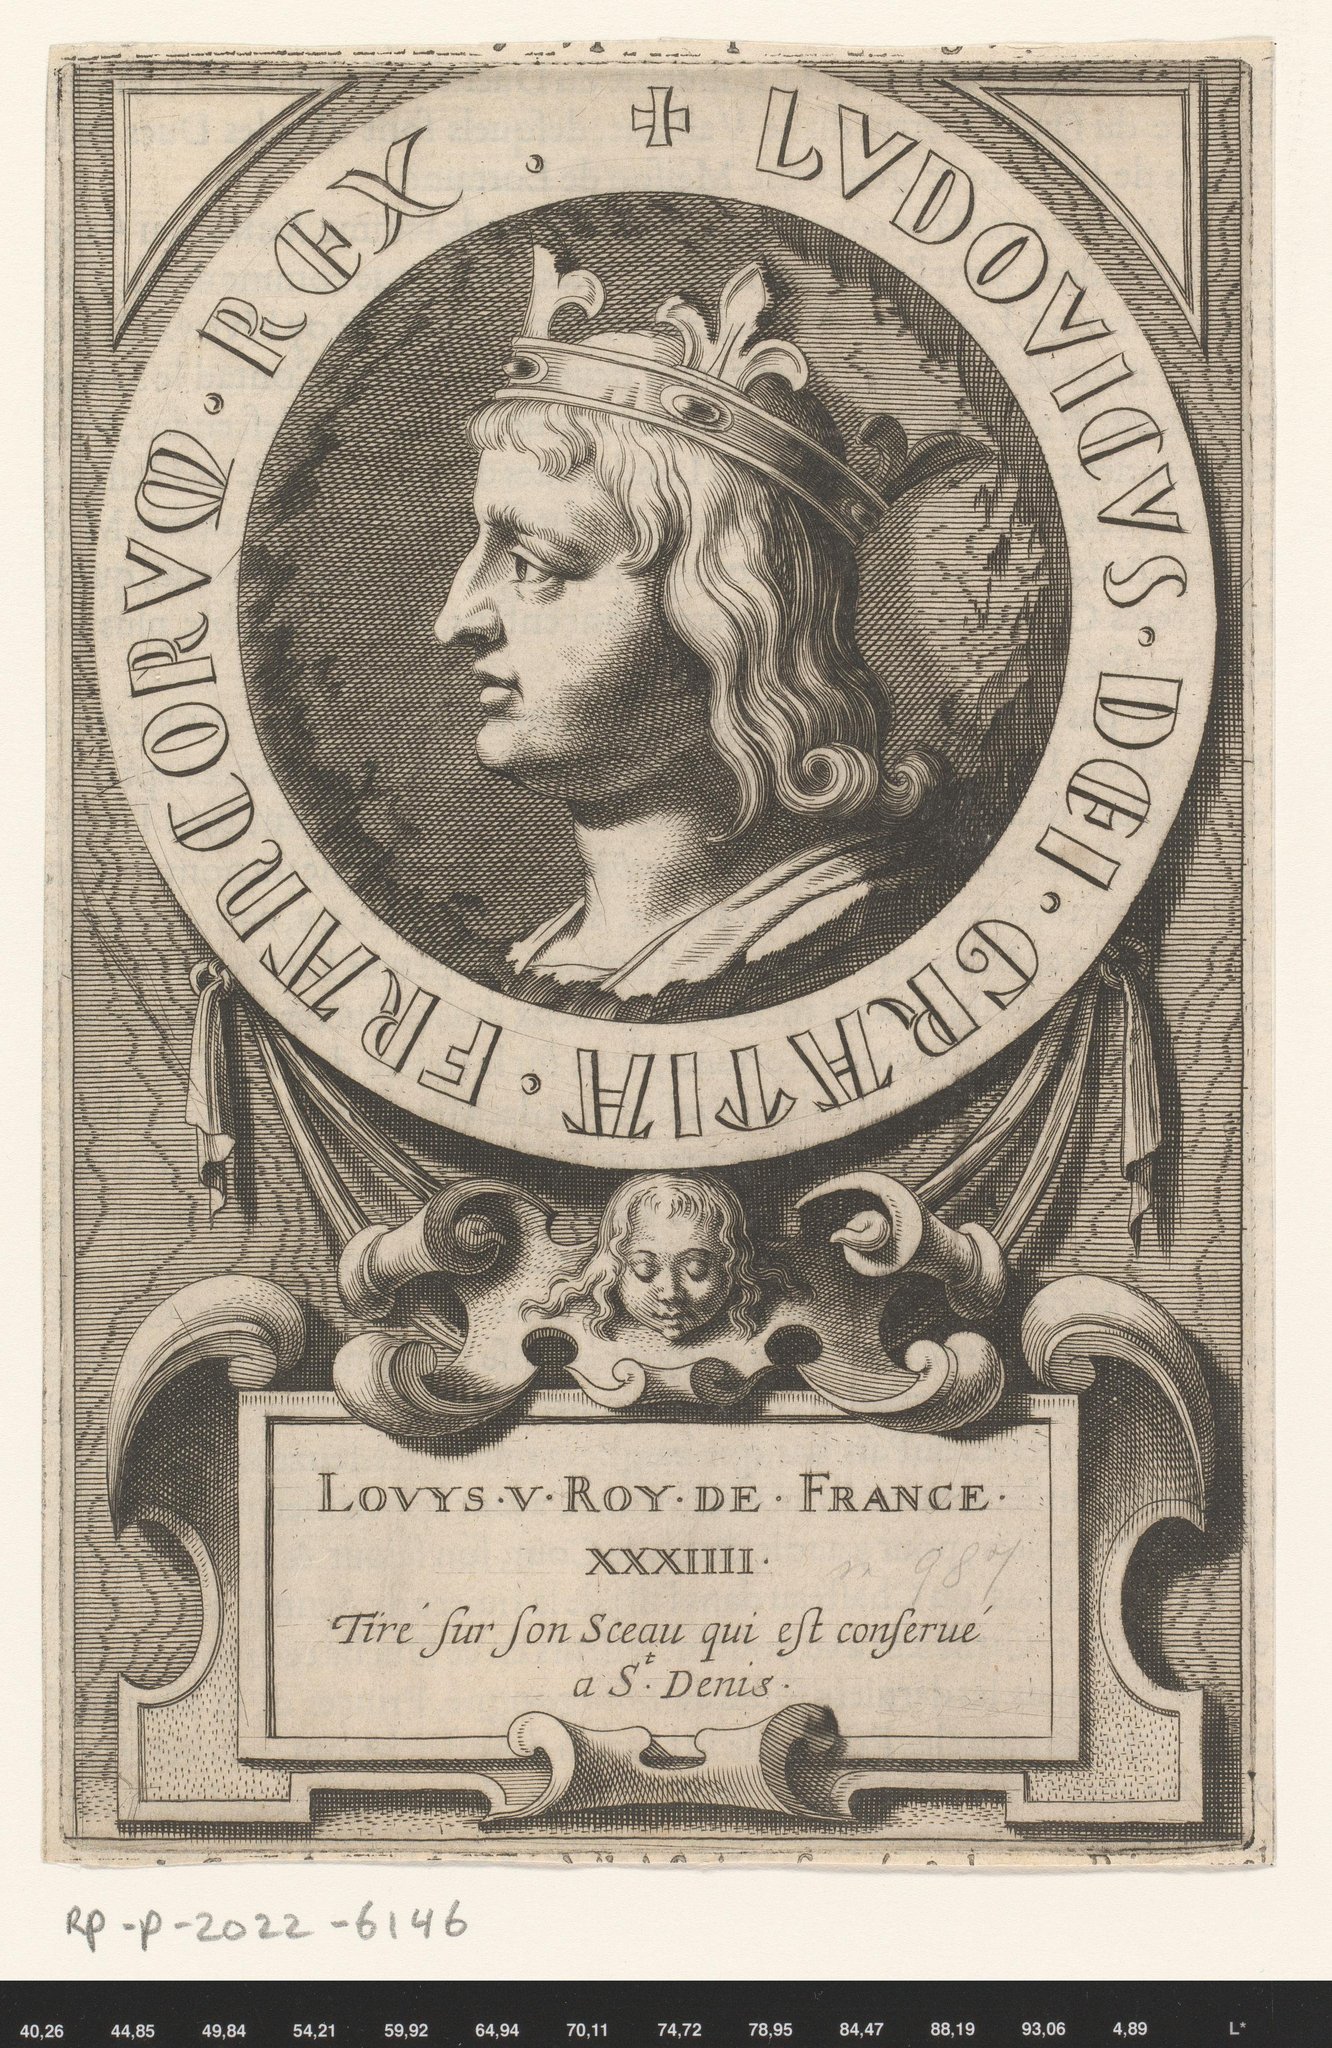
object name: print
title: Portret van Lodewijk V, koning van West-Francië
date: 1636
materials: paper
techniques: engraving, letterpress printing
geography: paris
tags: historical persons, king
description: Prent uit: Bie, Jacob de. Les vrais portraits des rois de France. (...) Parijs: Jean Camusat, 1636, dl. 2, p. 163.